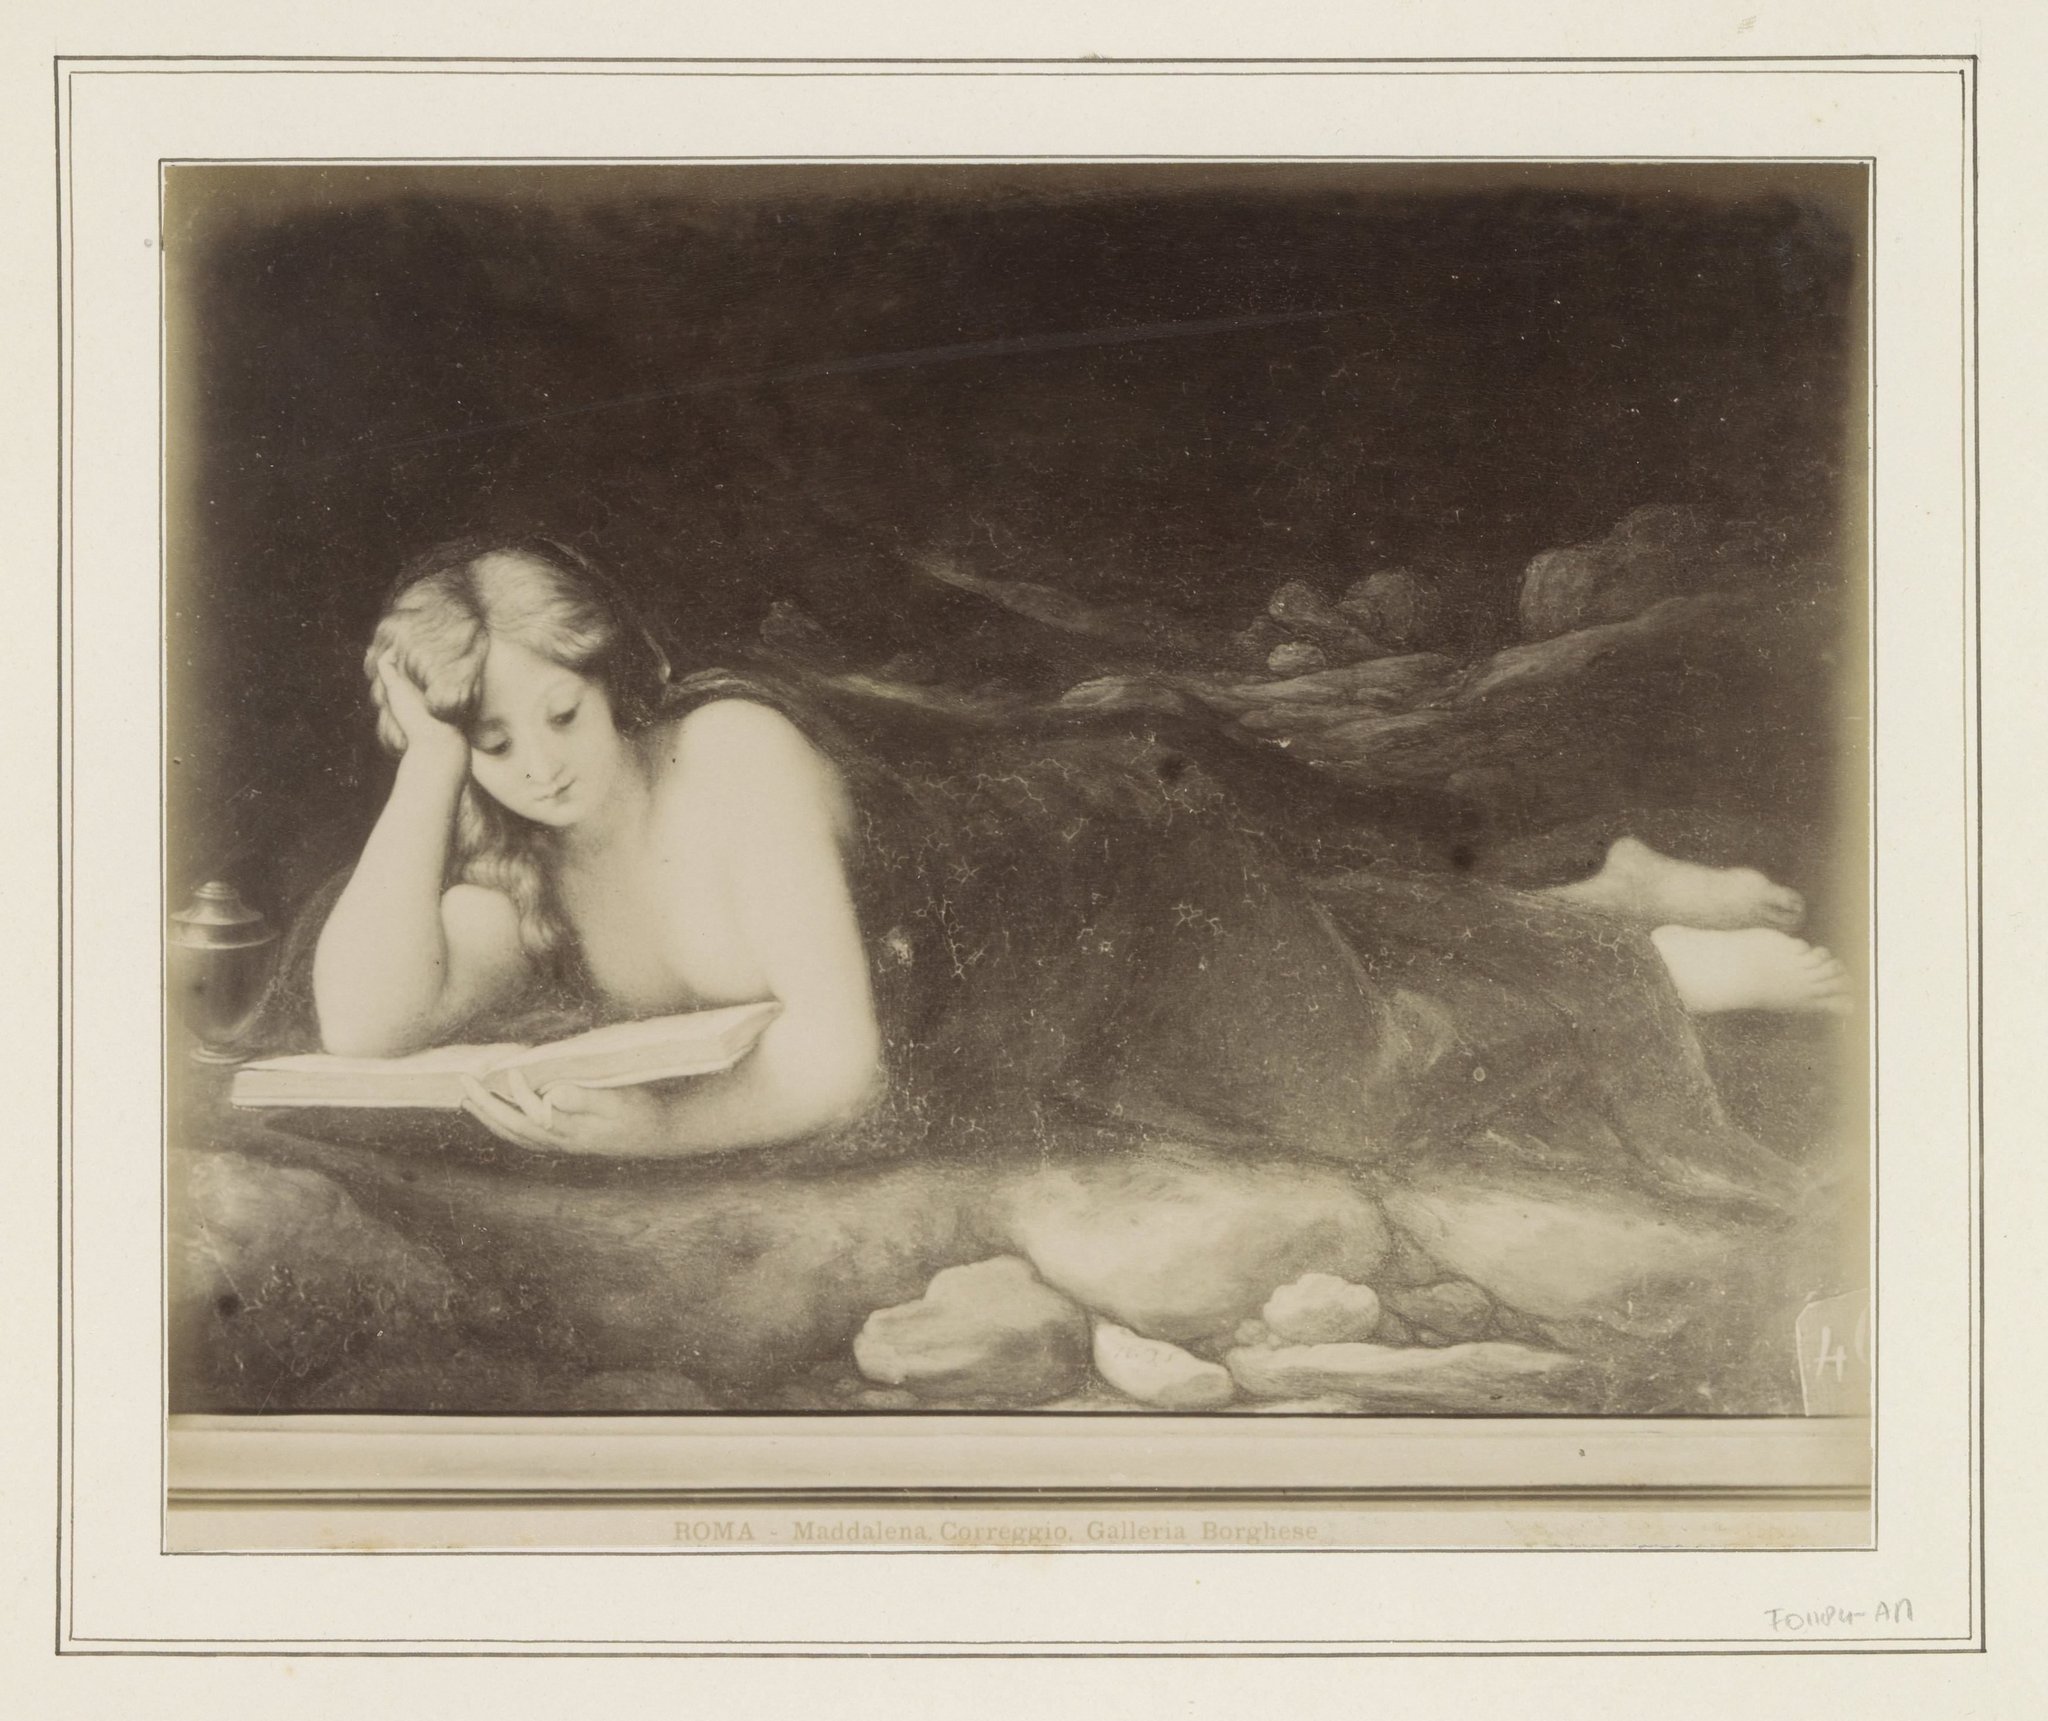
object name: reproduction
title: Fotoreproductie van een schilderij naar Antonio da Correggio, voorstellend de boetedoening van Maria Magdalena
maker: Anonymous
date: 1865-1890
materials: paper, photographic support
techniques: albumen print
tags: the penitent harlot mary magdalene; possible attributes: book (or scroll), crown, crown of thorns, crucifix, jar of ointment, mirror, musical instrument, palm-branch, rosary, scourge, rome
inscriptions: negative number: ‘4[...]’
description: Onderdeel van Reisalbum met foto's van bezienswaardigheden in Italië (deel I).